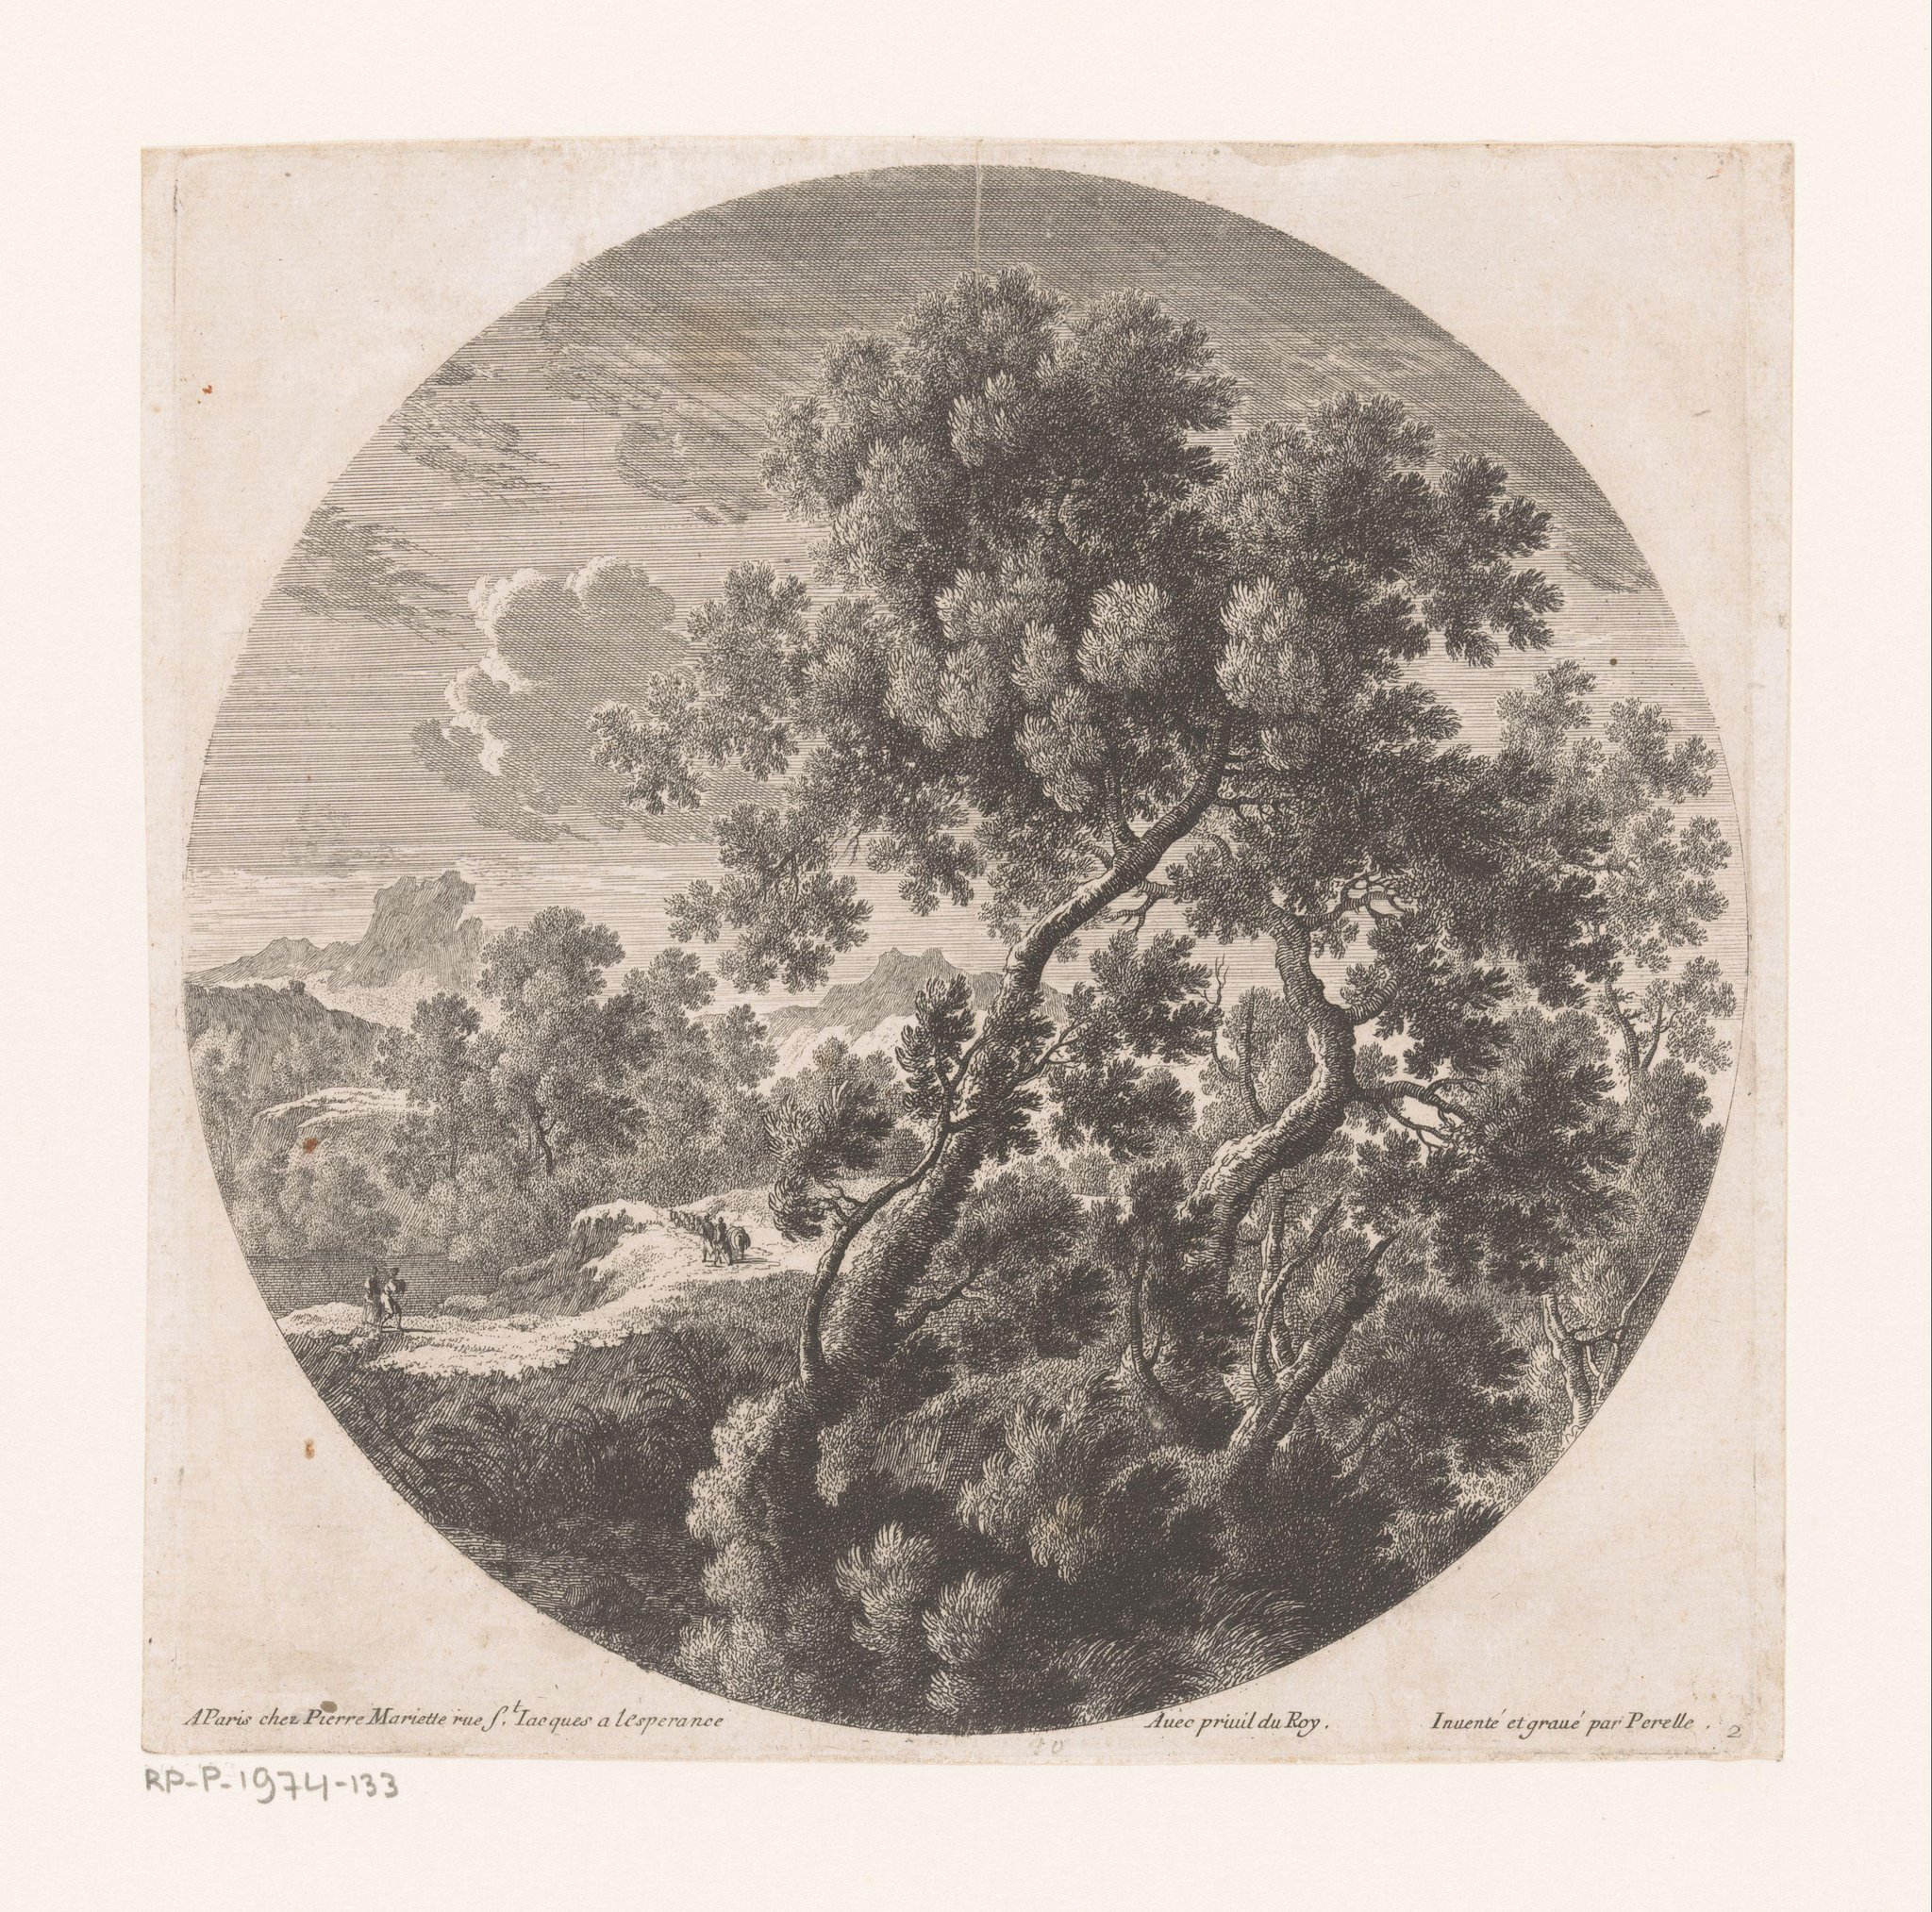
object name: print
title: Landschap met herders met kudde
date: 1613-1677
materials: paper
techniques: engraving, etching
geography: france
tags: landscapes (+ landscape with figures, staffage), herd, flock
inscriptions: collector's mark: Lugt 2228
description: Prenten met het signatuur 'Perelle' kunnen zowel door vader Gabriel als door zonen Nicolas en Adam gemaakt zijn.